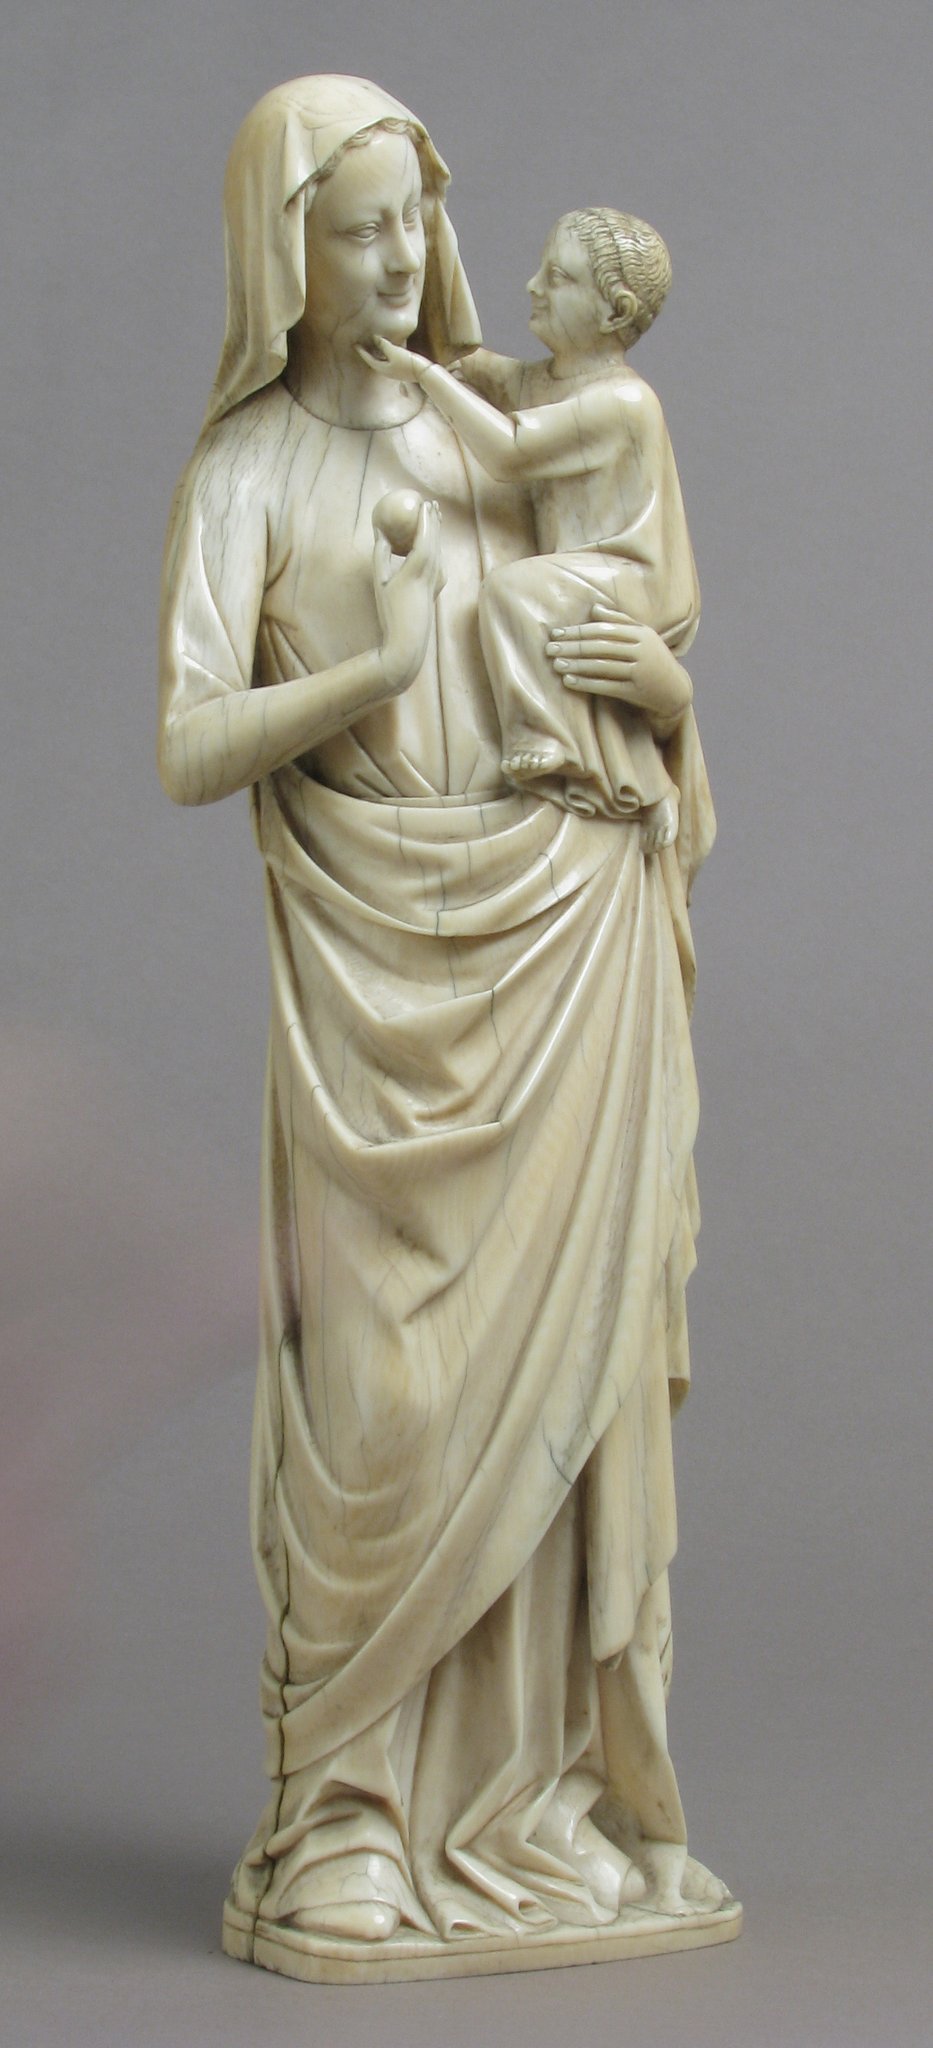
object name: sculpture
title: Virgin and Child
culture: european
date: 1801-1900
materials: ivory